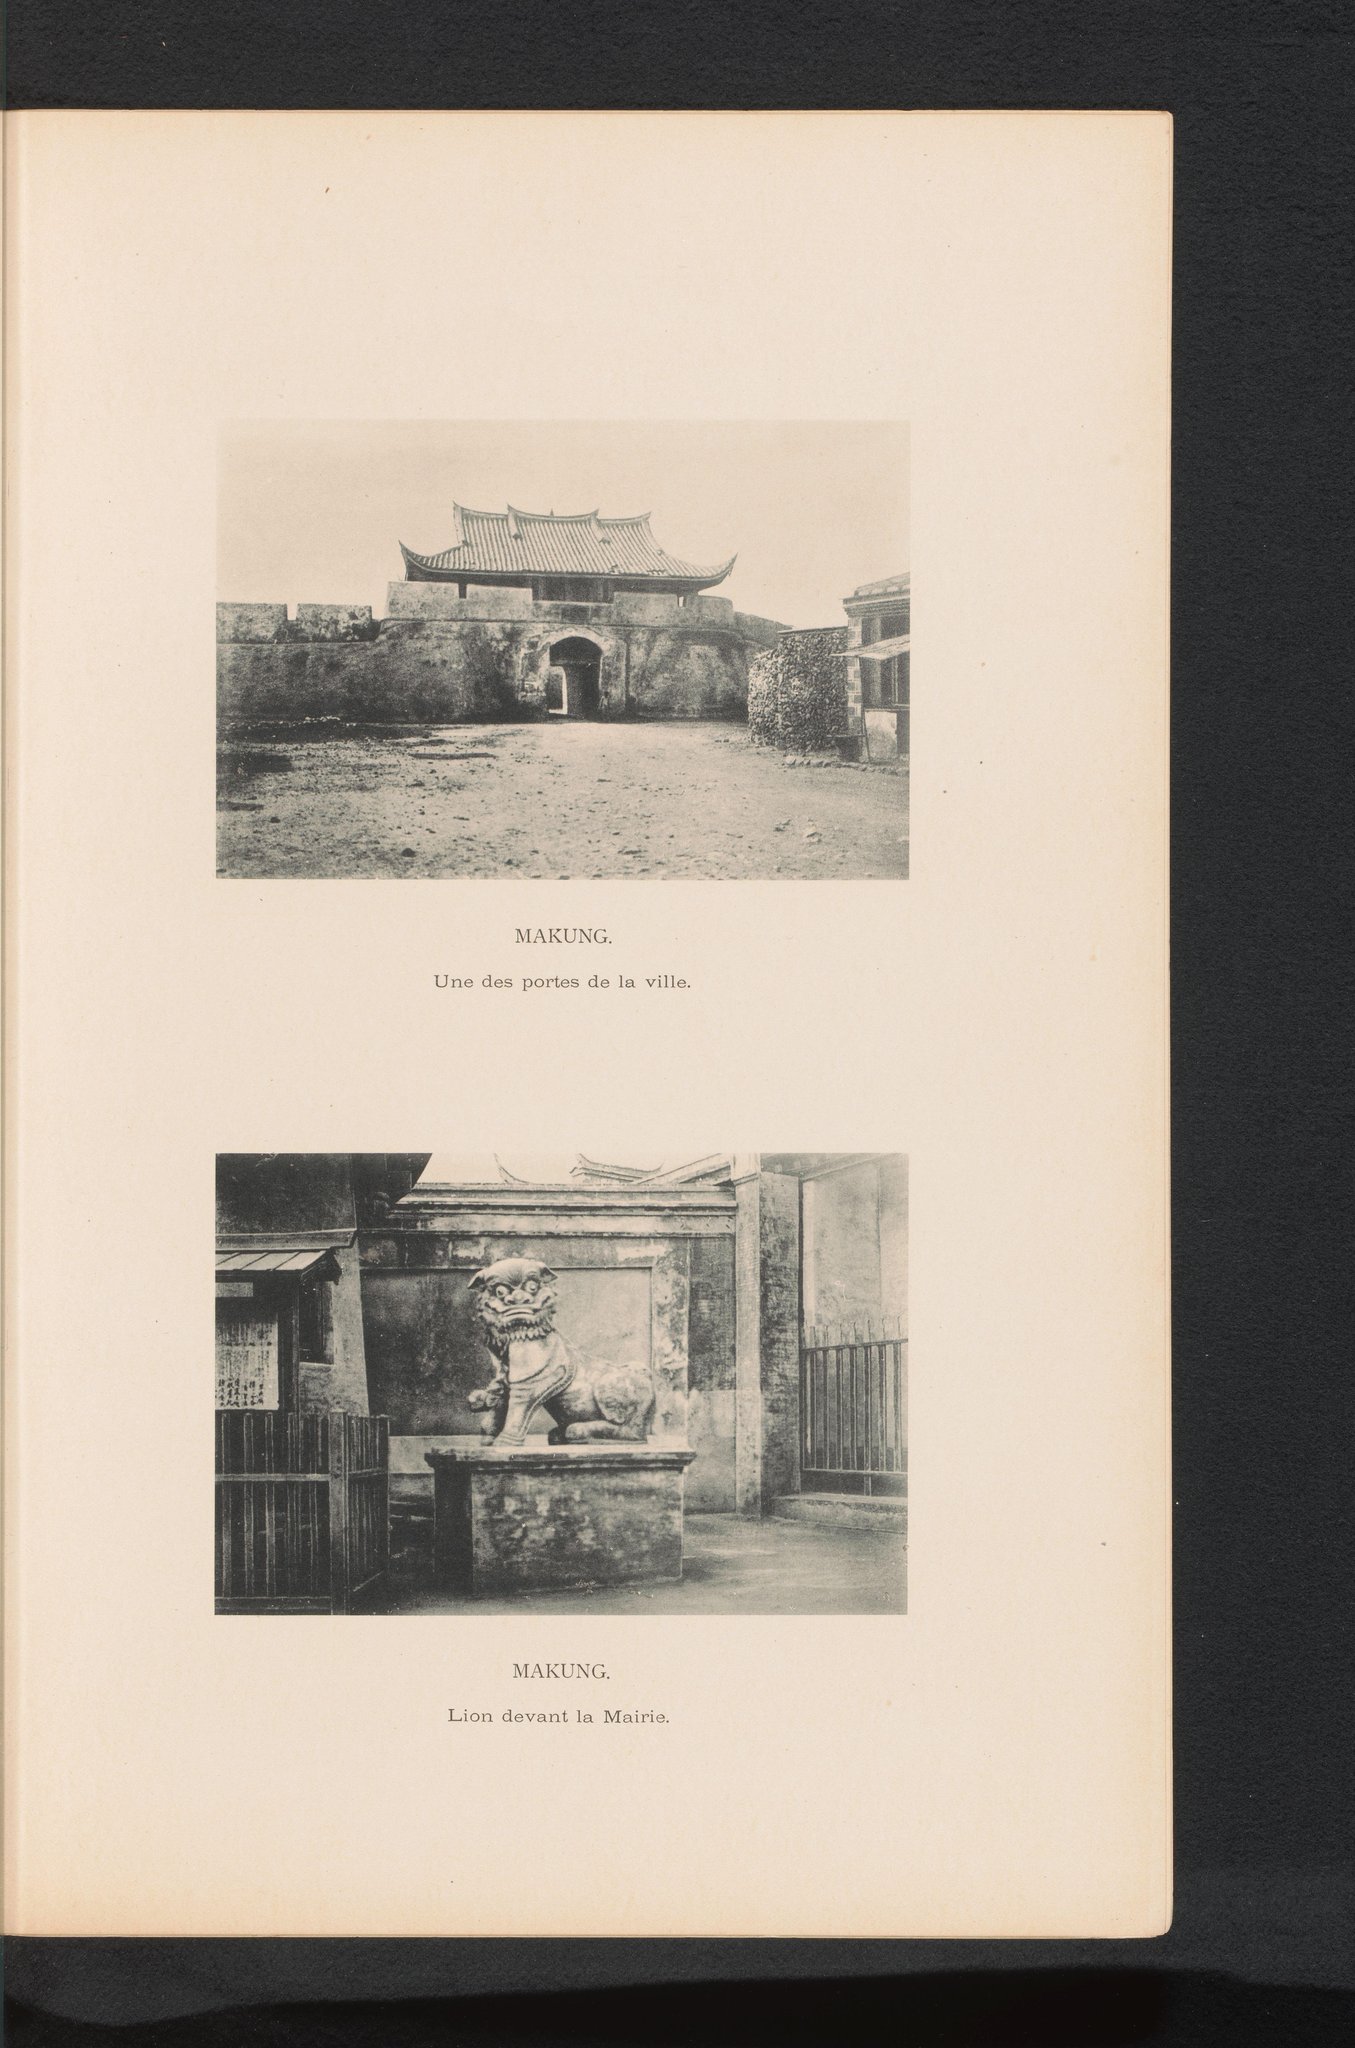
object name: page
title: Makung. Une des portes de la ville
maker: Anonymous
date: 1891-1896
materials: paper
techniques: photograph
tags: lion's head ~ ornament, city-gate